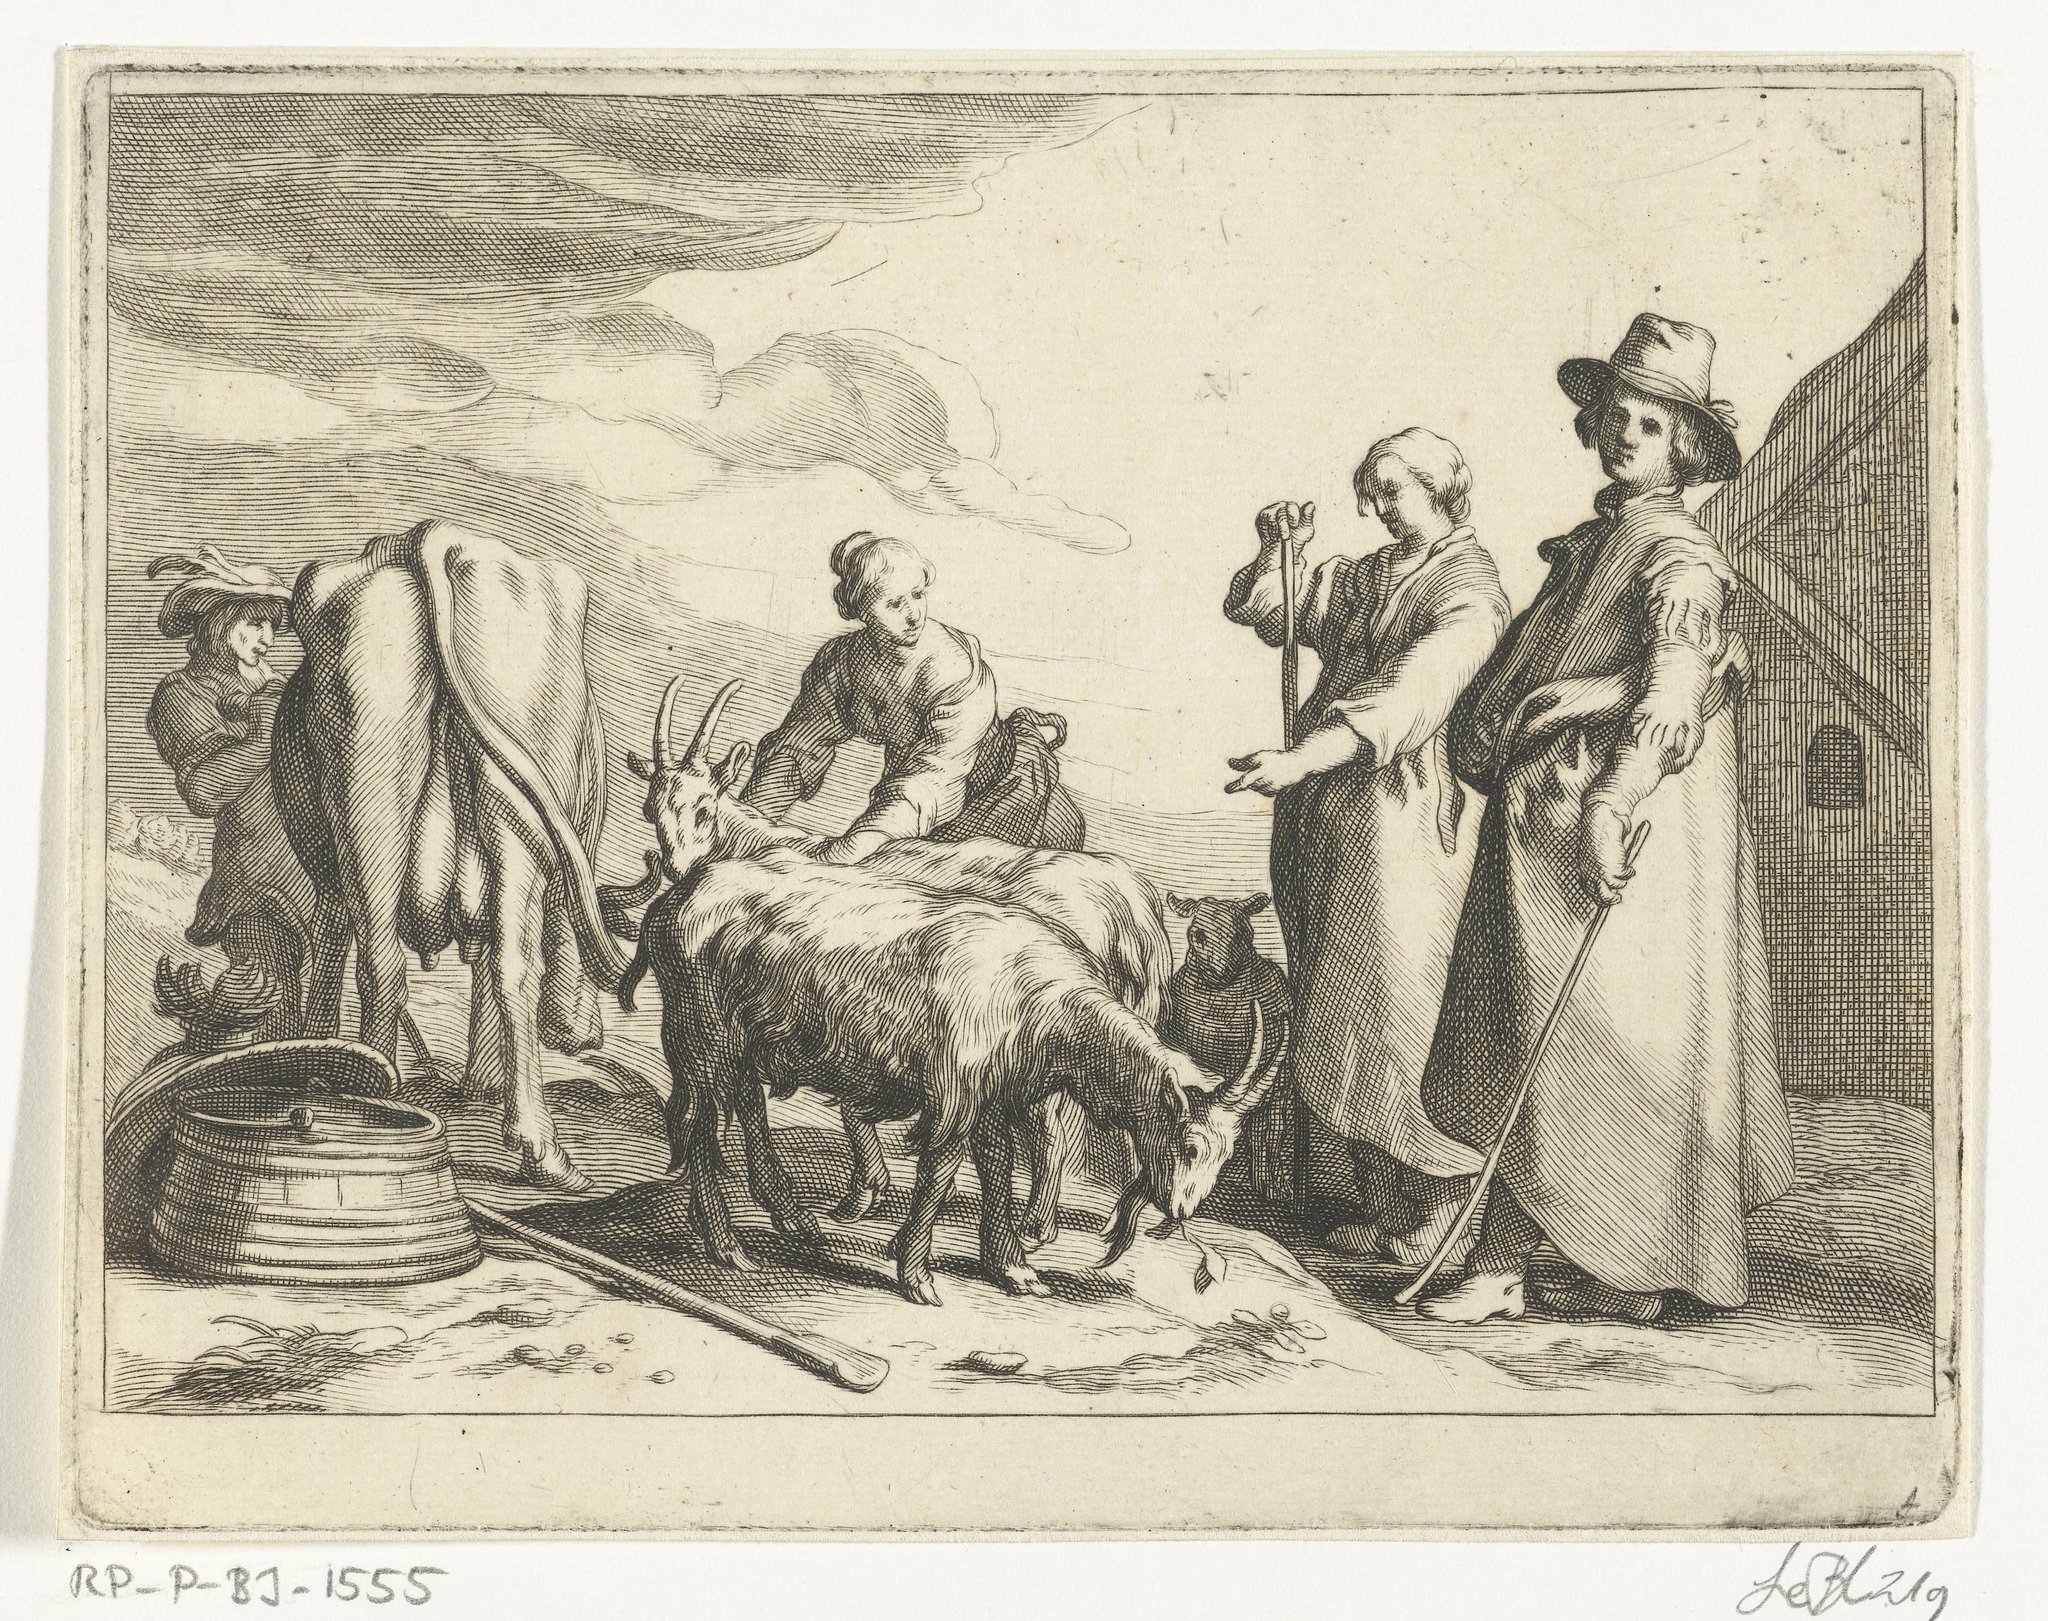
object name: print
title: De maanden van het Jaar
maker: frederick bloemaert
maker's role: print maker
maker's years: 1614-1669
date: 1635-1670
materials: paper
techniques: engraving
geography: utrecht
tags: april and its 'labours', herd, flock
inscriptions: collector's mark: Lugt 240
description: Wellicht proefdruk voor de letter, of latere uitgave waarbij de opschriften zijn weggepolijst.